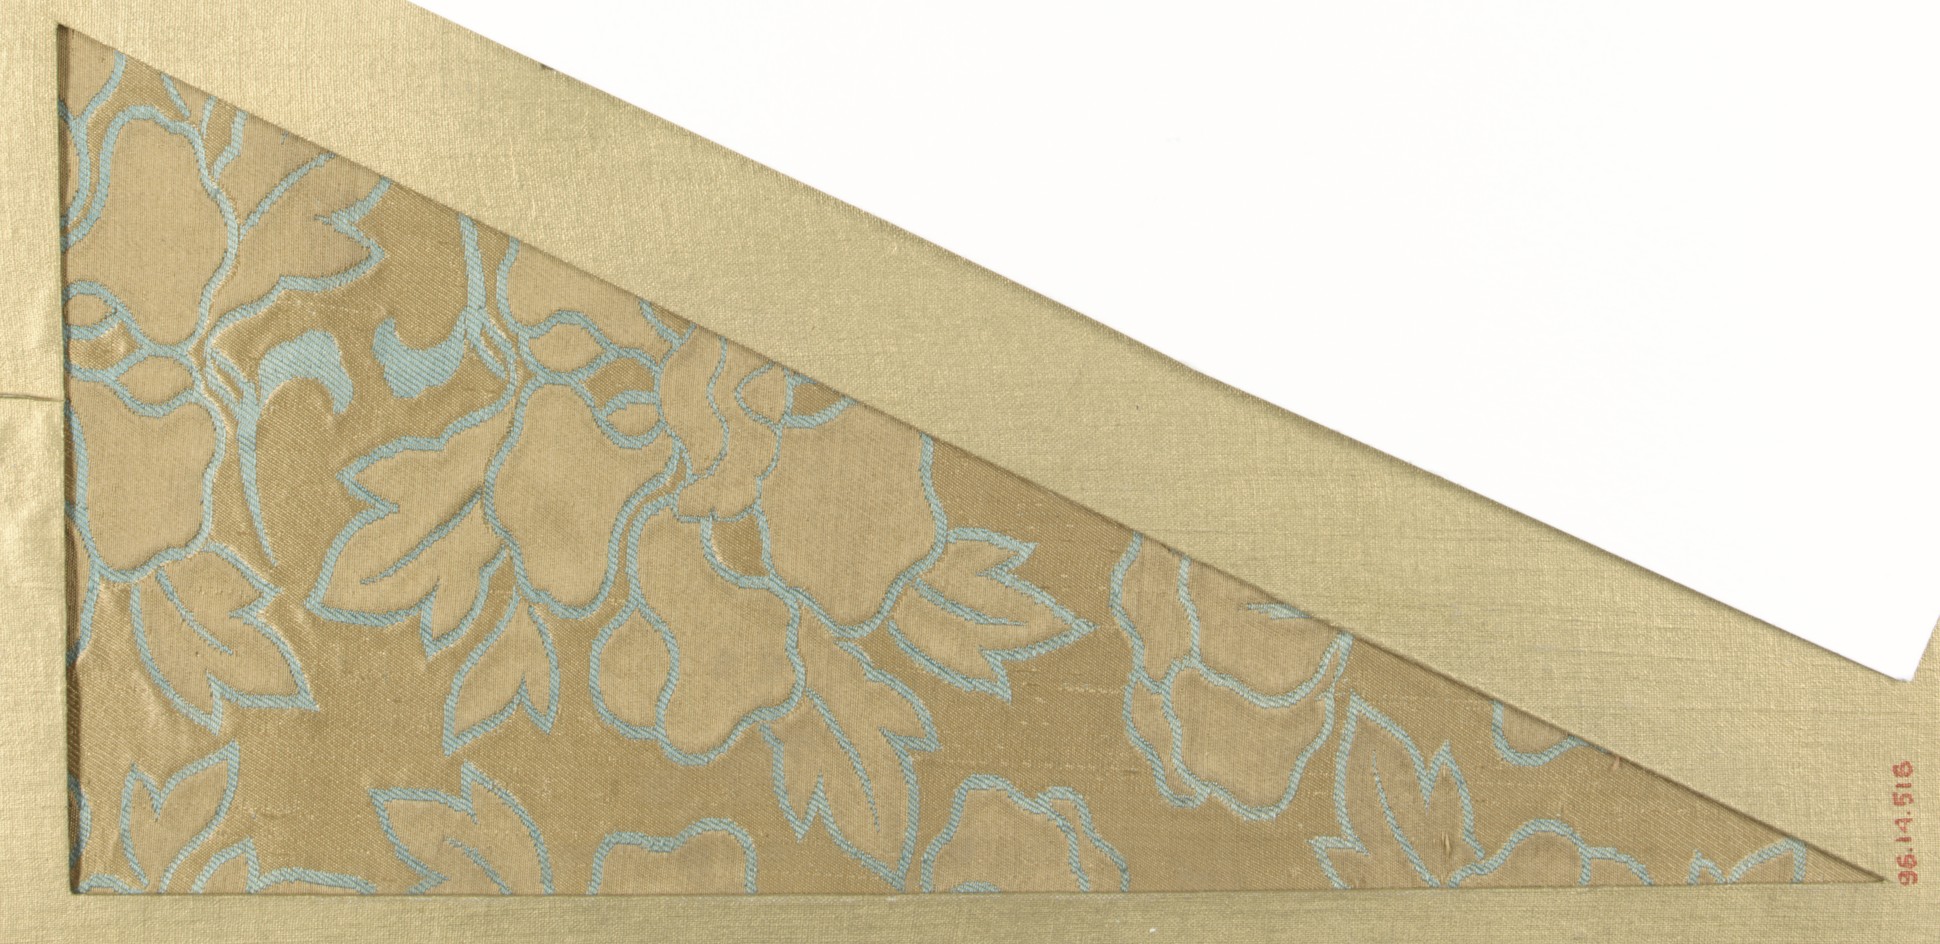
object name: piece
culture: japanese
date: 1701-1900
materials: silk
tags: leaves